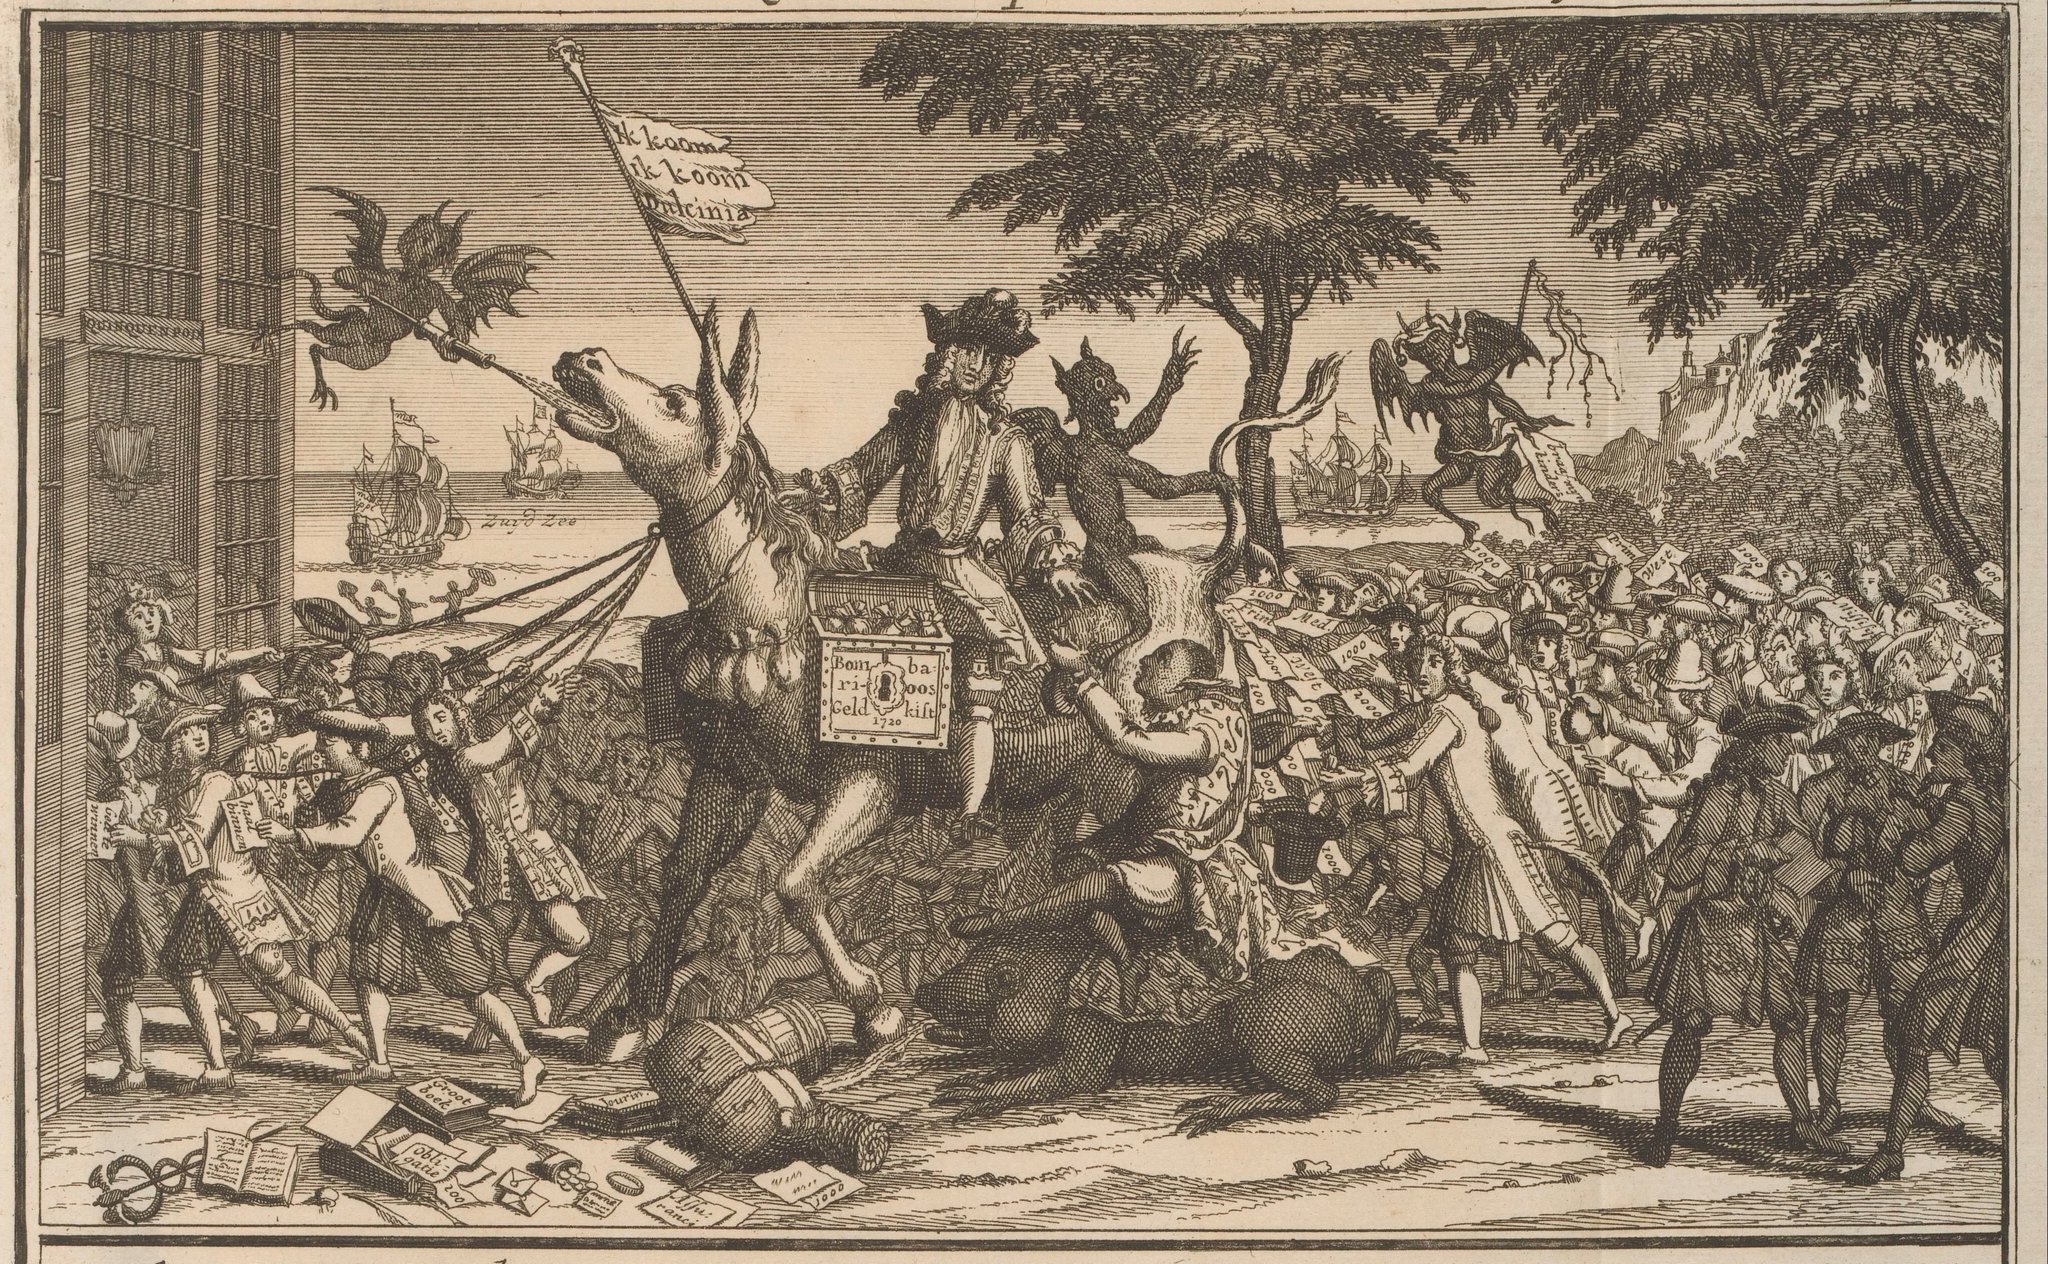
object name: cartoon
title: Het Groote Tafereel der Dwaasheid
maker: Anonymous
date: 1720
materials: paper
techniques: etching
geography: northern netherlands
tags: financial panic, don quixote, sancho panza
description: Spotprent op John Law rijdend als een tweede Don Quichotte op de ezel van Sancho Panza, 1720. De duivel tilt de staart van de ezel op waardoor actien uit de achterste gescheten worden. De windhandelaren trekken de ezel richting Koffiehuis Quincampoix. Prent in de gebonden eerste uitgave (304 B 10) van Het Groote Tafereel der Dwaasheid met spotprenten op de Windhandel of Actiehandel van 1720.